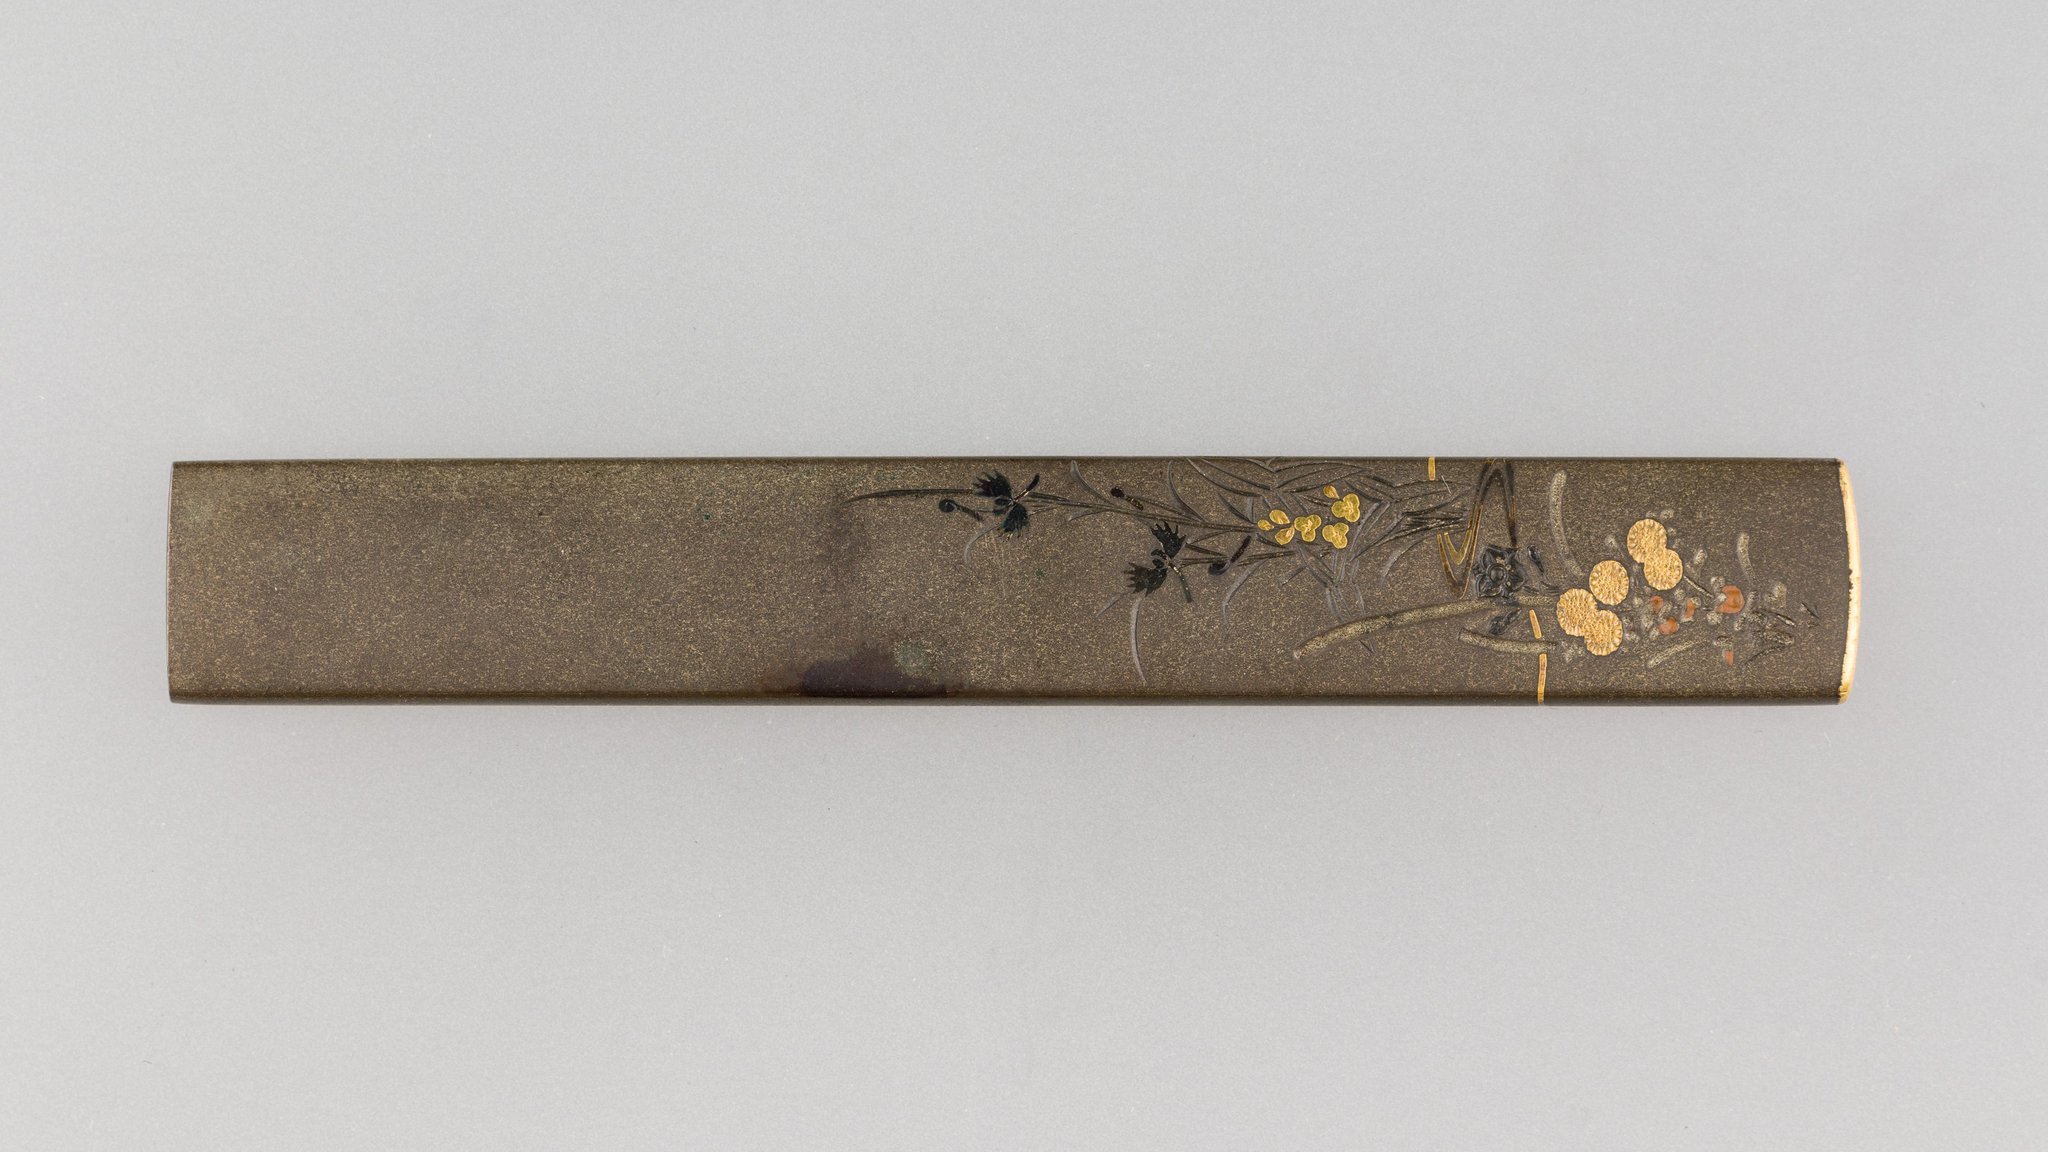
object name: knife handle kozuka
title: Knife Handle (Kozuka)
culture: japanese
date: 1785-1876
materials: copper, gold alloy, silver alloy, gold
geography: japan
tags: plants